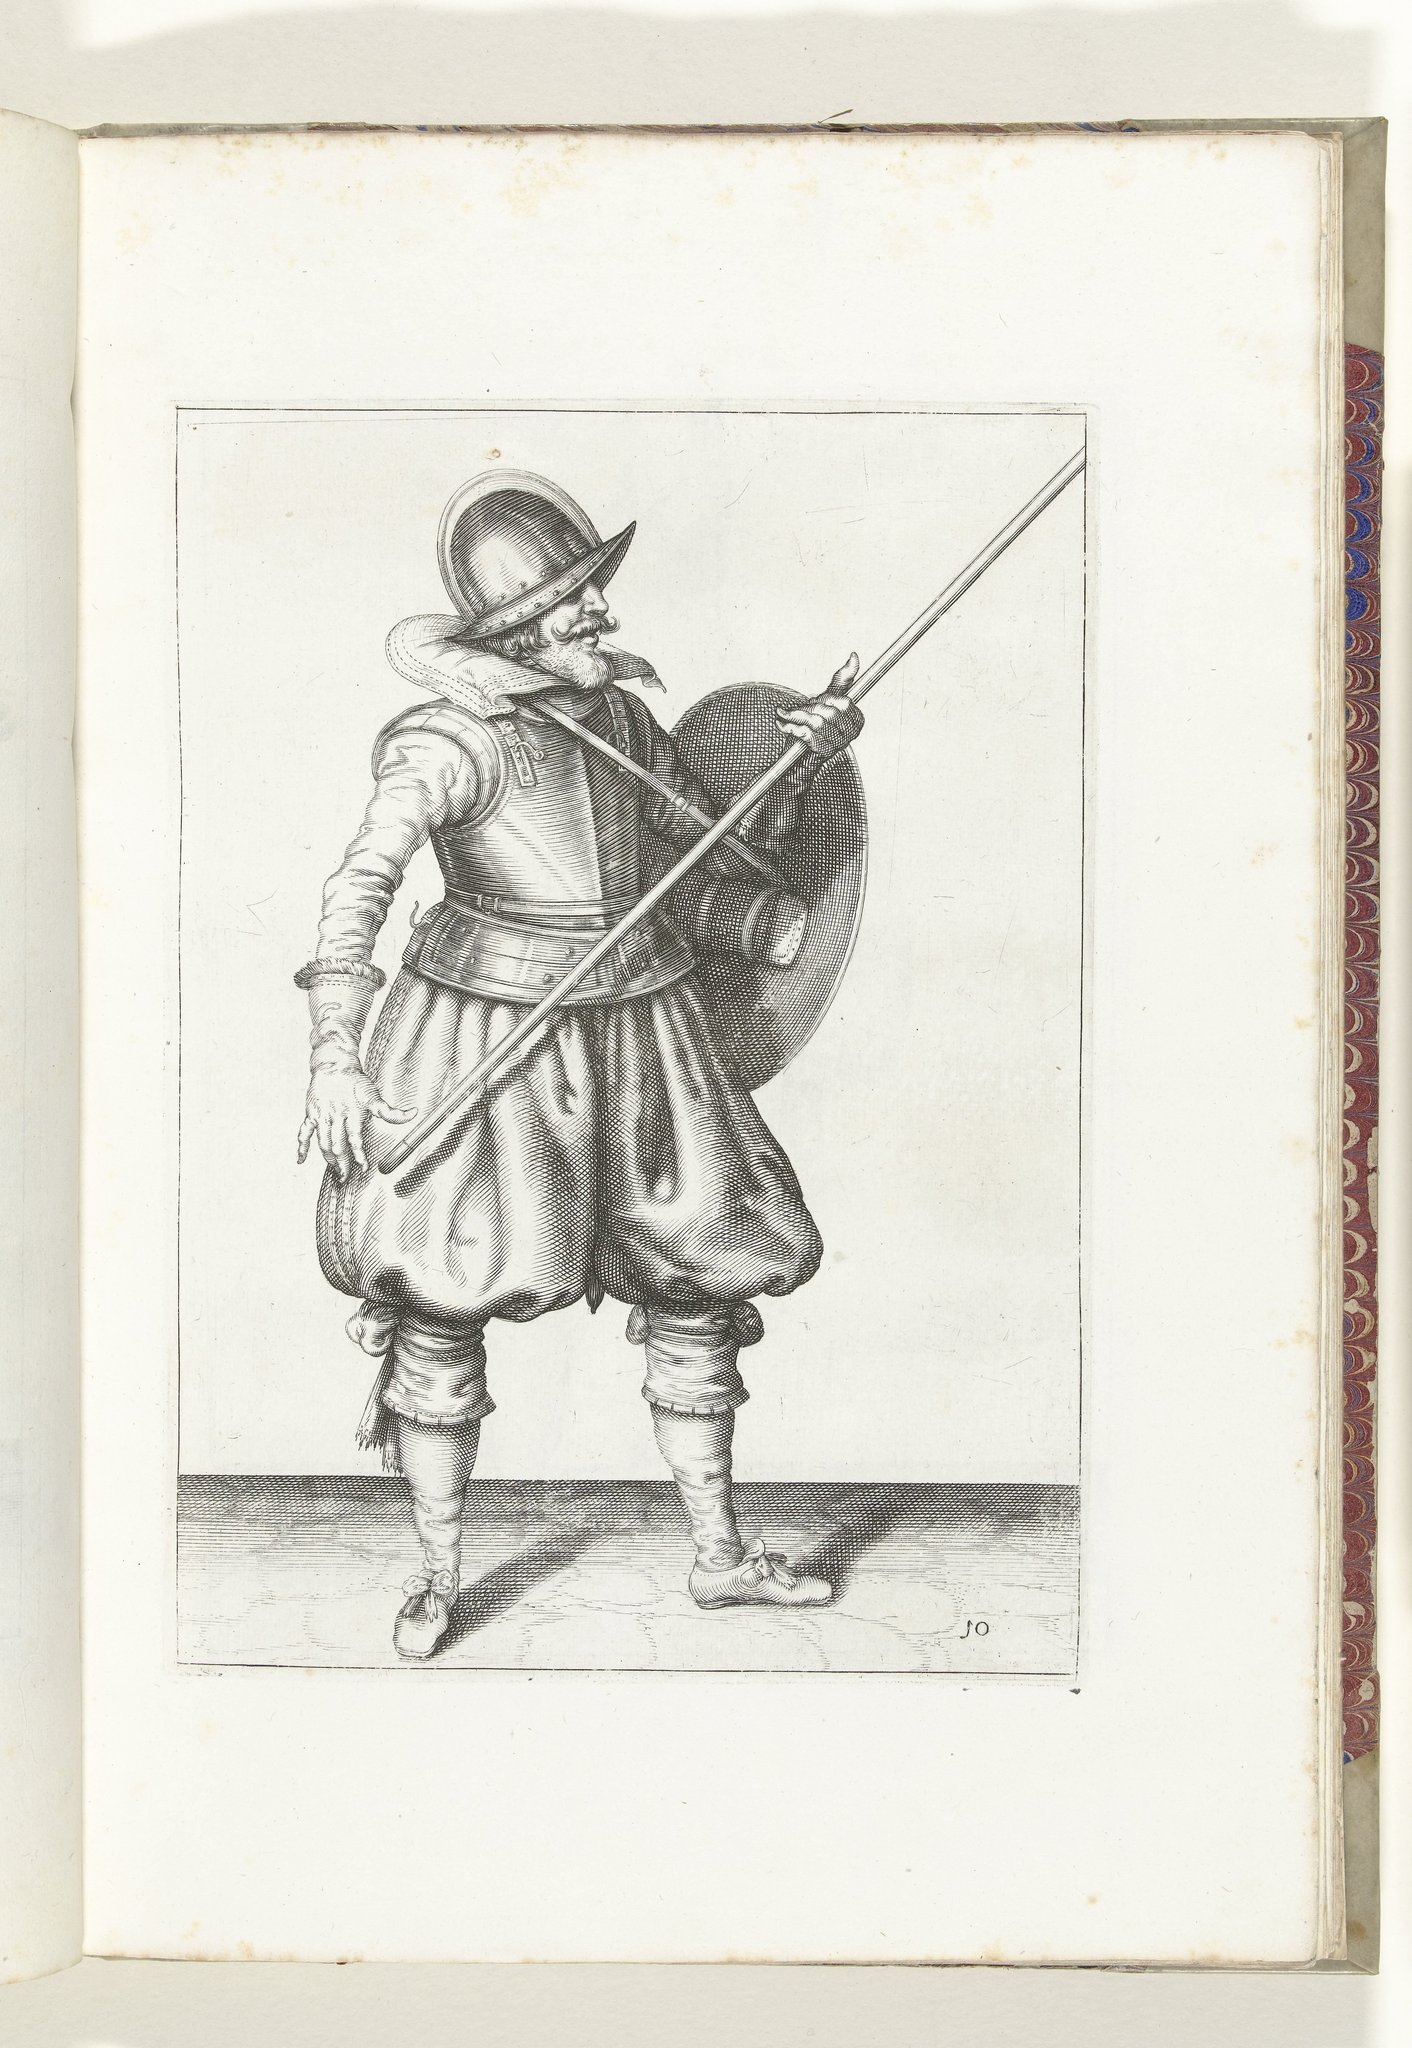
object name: print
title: De exercitie met schild en spies: de soldaat brengt in drie tijden de spies weer terug in de rustpositie, eerste beweging (nr. 10), 1618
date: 1616-1618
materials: paper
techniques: engraving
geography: northern netherlands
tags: the hague, maurice (prince of orange), handling of weapons ~ military training, weapons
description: Illustratie in: Adam van Breen, De Nassausche Wapen-Handelinge, van Schilt, Spies, Rappier ende Targe : beyde figuerlick afgebeelt, ende gestelt na de nieu ordening [van] ... Maurits van Nassau, 's-Gravenhage, [Aert Meuris] 1618, plaat nr. 10. In het exemplaar in de collectie van de Rijksmuseum Research Library (326 F 22).